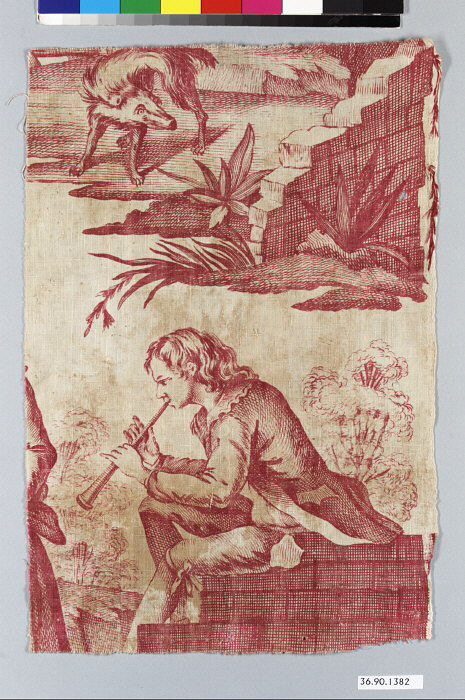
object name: piece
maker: oberkampf manufactory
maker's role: manufactory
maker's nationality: french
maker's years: 1760-1843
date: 1785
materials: cotton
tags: musical instruments,animals,leaves,musicians